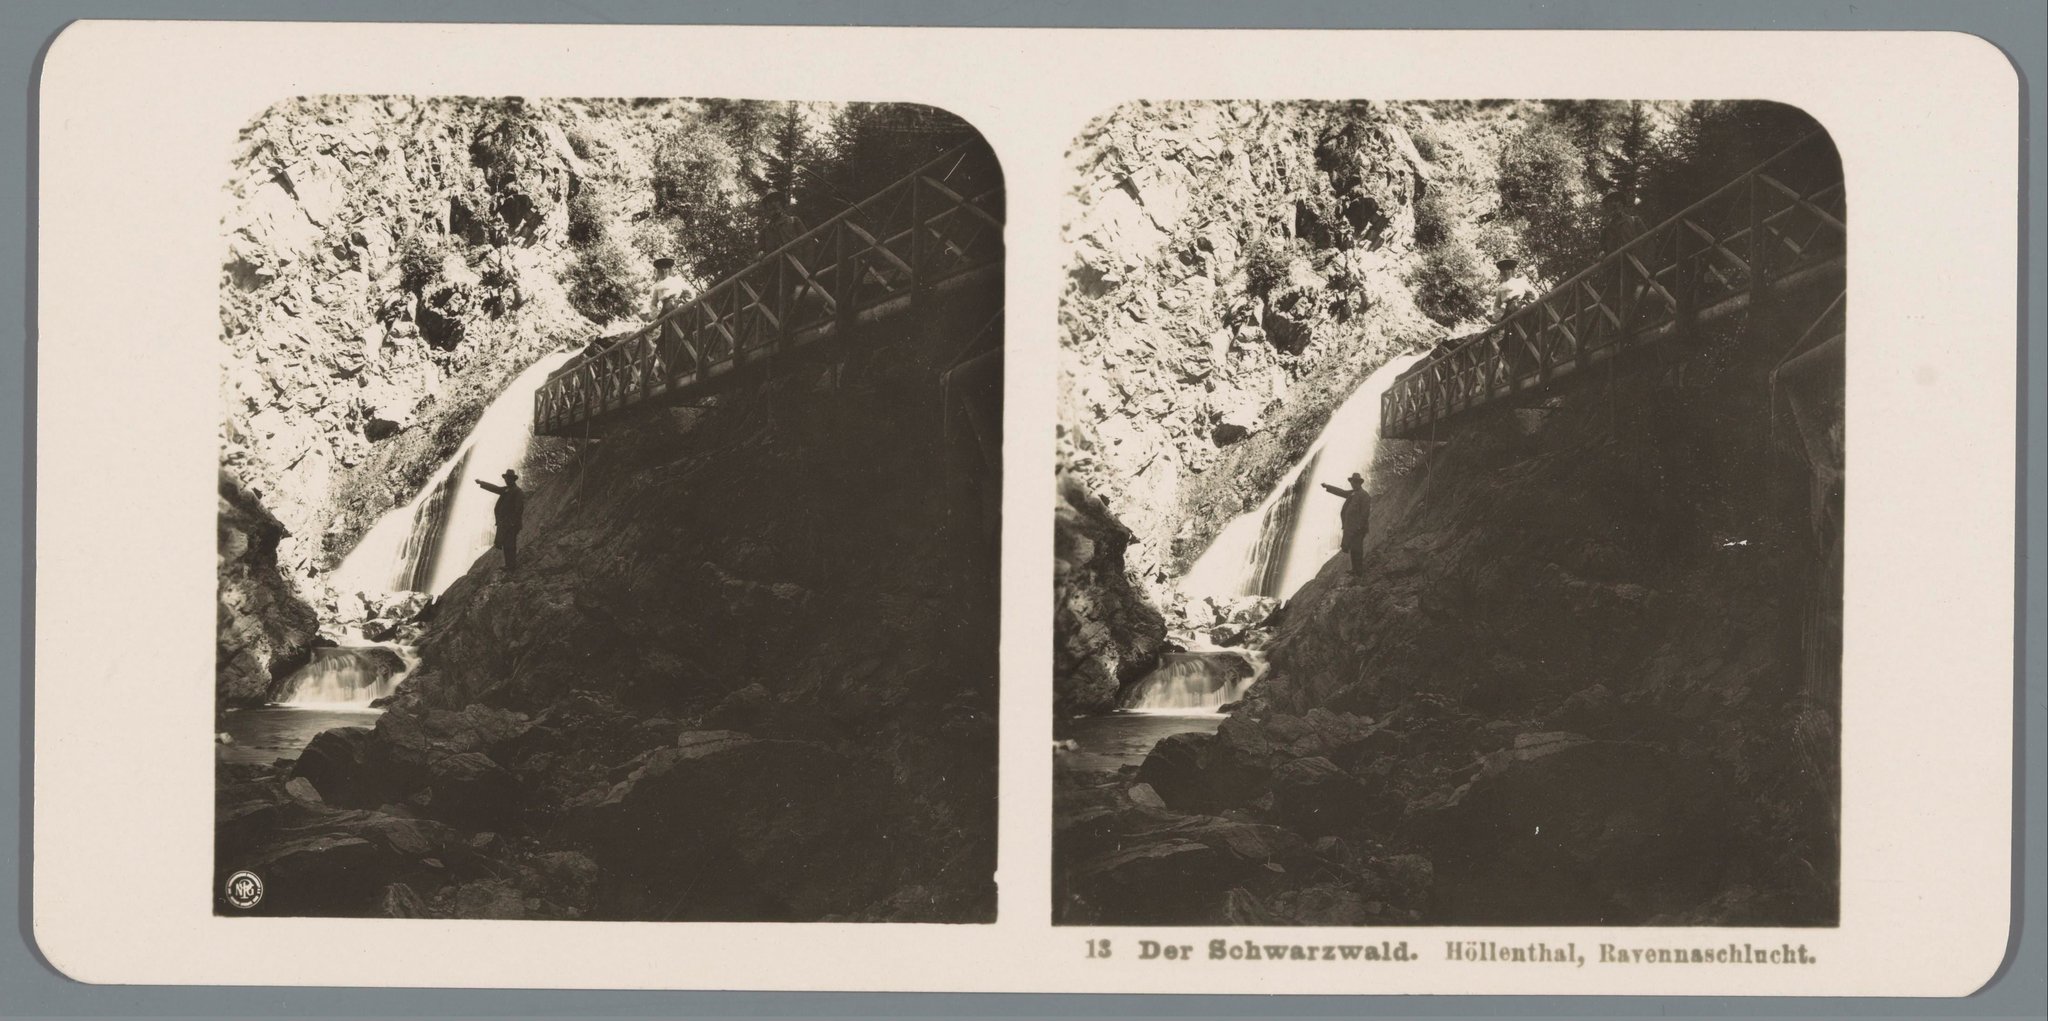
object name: stereograph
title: Der Schwarzwald. Höllental, Ravennaschlucht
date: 1900-1910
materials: cardboard, photographic support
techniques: gelatin silver print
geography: höllental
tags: waterfall, ravine, chasm, abyss, canyon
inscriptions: number: ‘13’, inscription: ‘NPG’